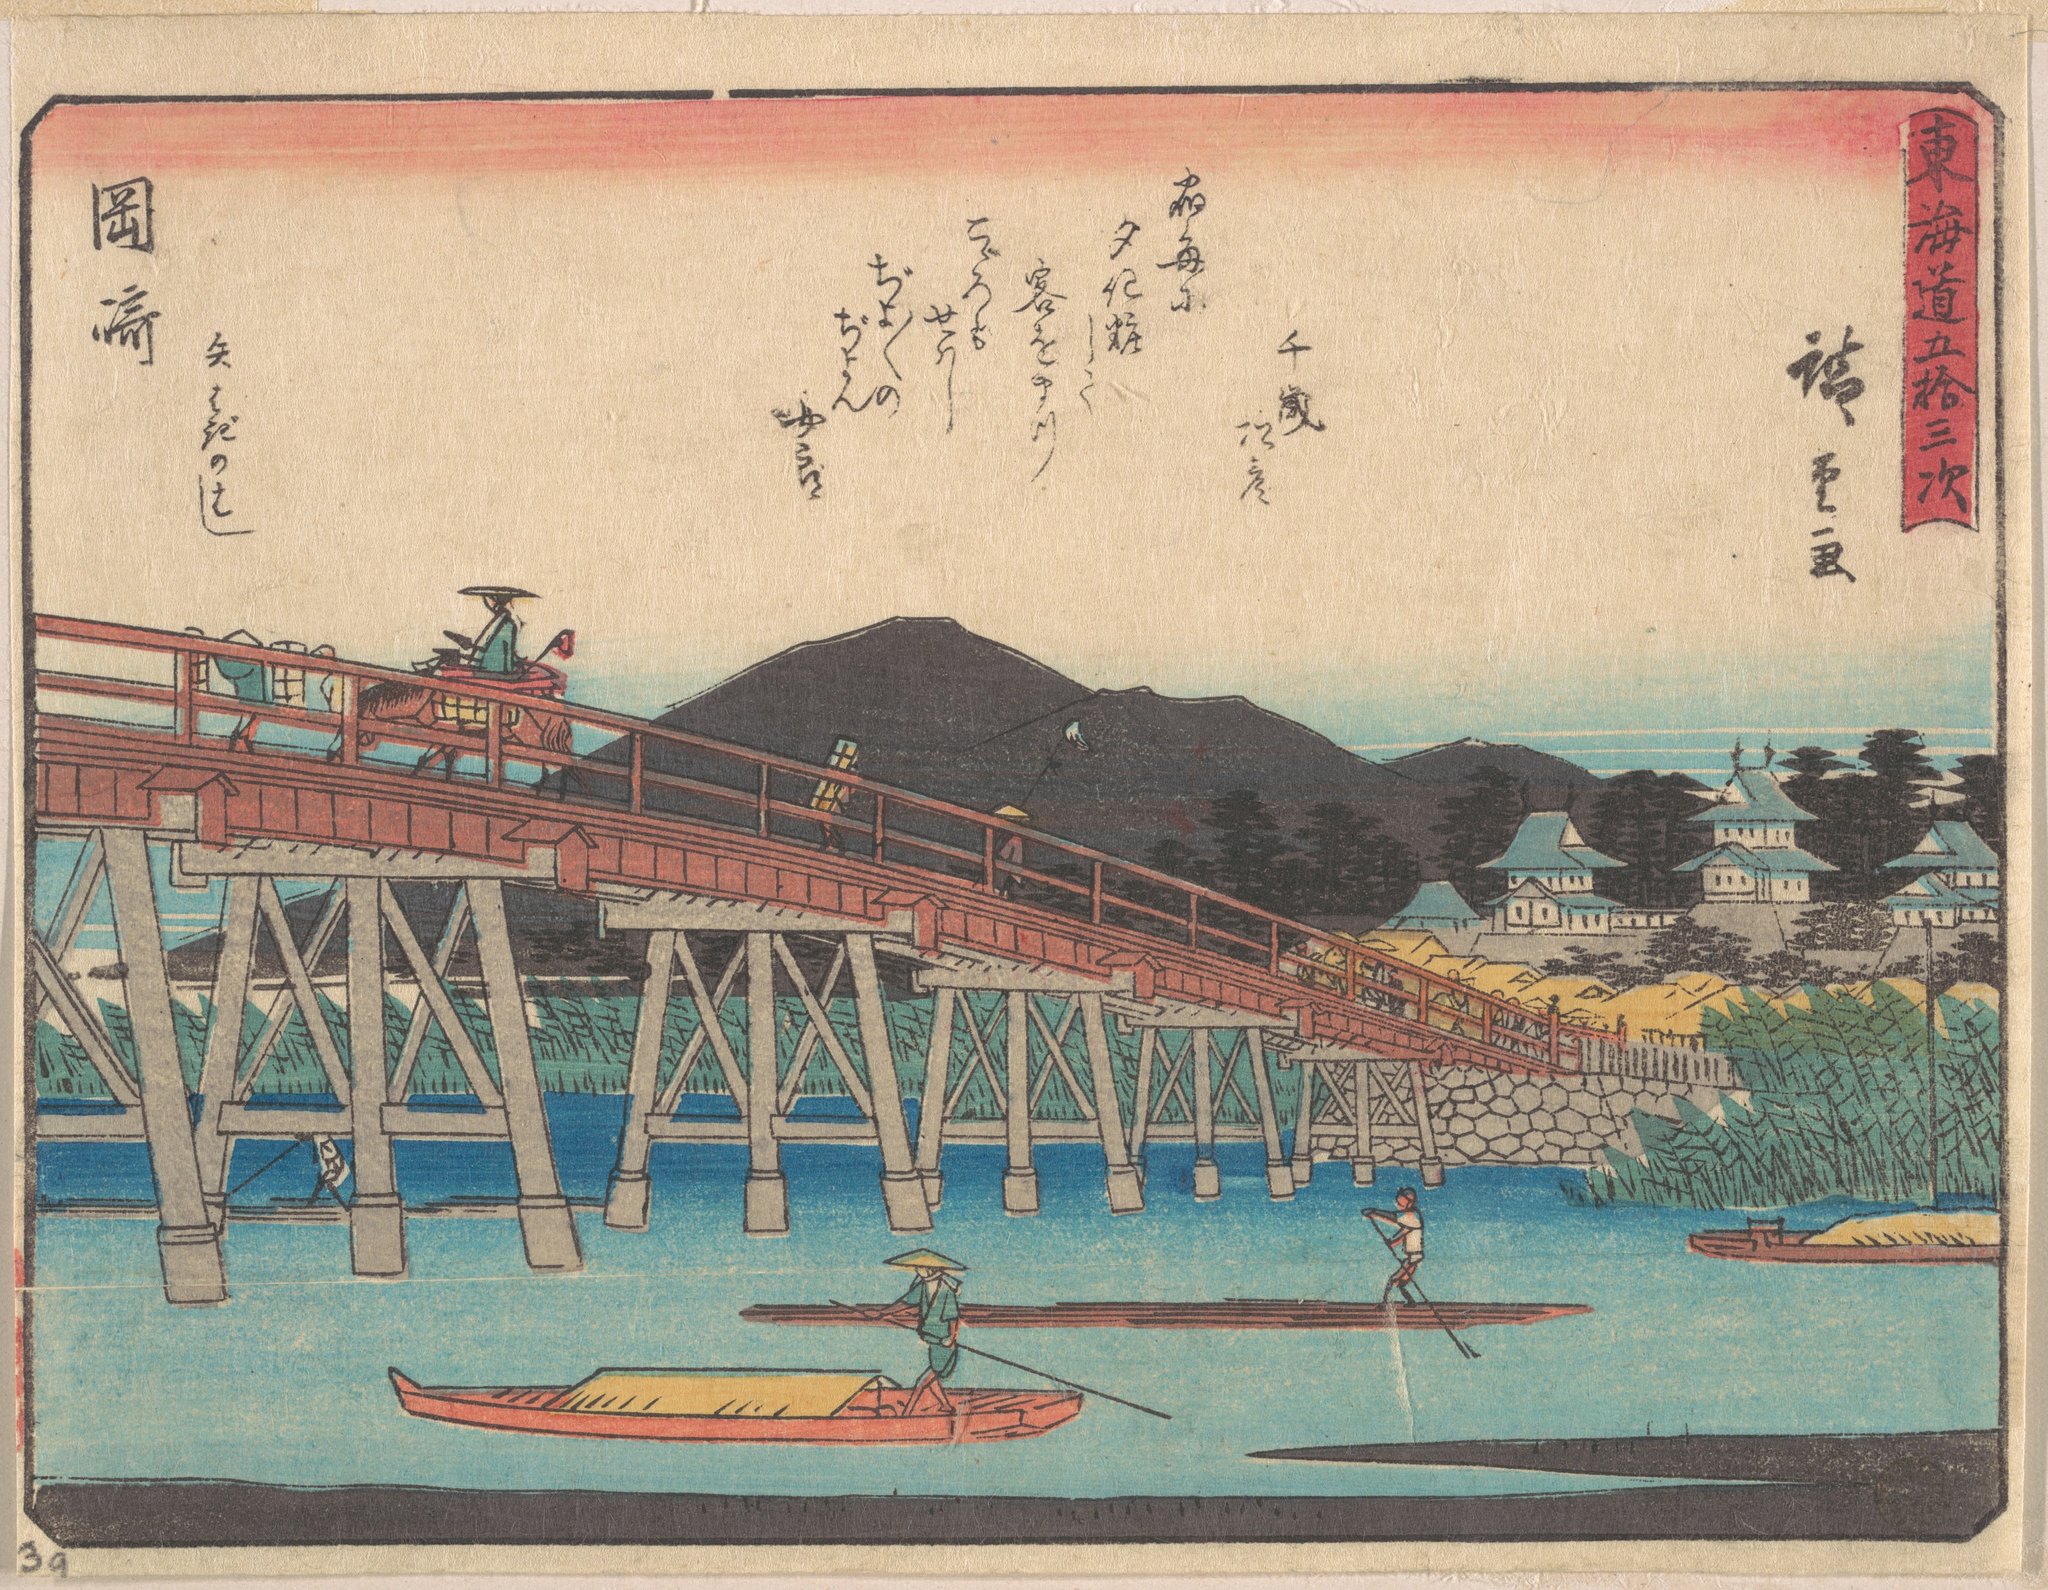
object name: print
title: Okazaki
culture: japanese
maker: utagawa hiroshige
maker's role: artist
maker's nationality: japanese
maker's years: 1797-1858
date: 1838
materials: ink, paper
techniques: woodblock print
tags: human figures,buildings,bridges,mountains,boats